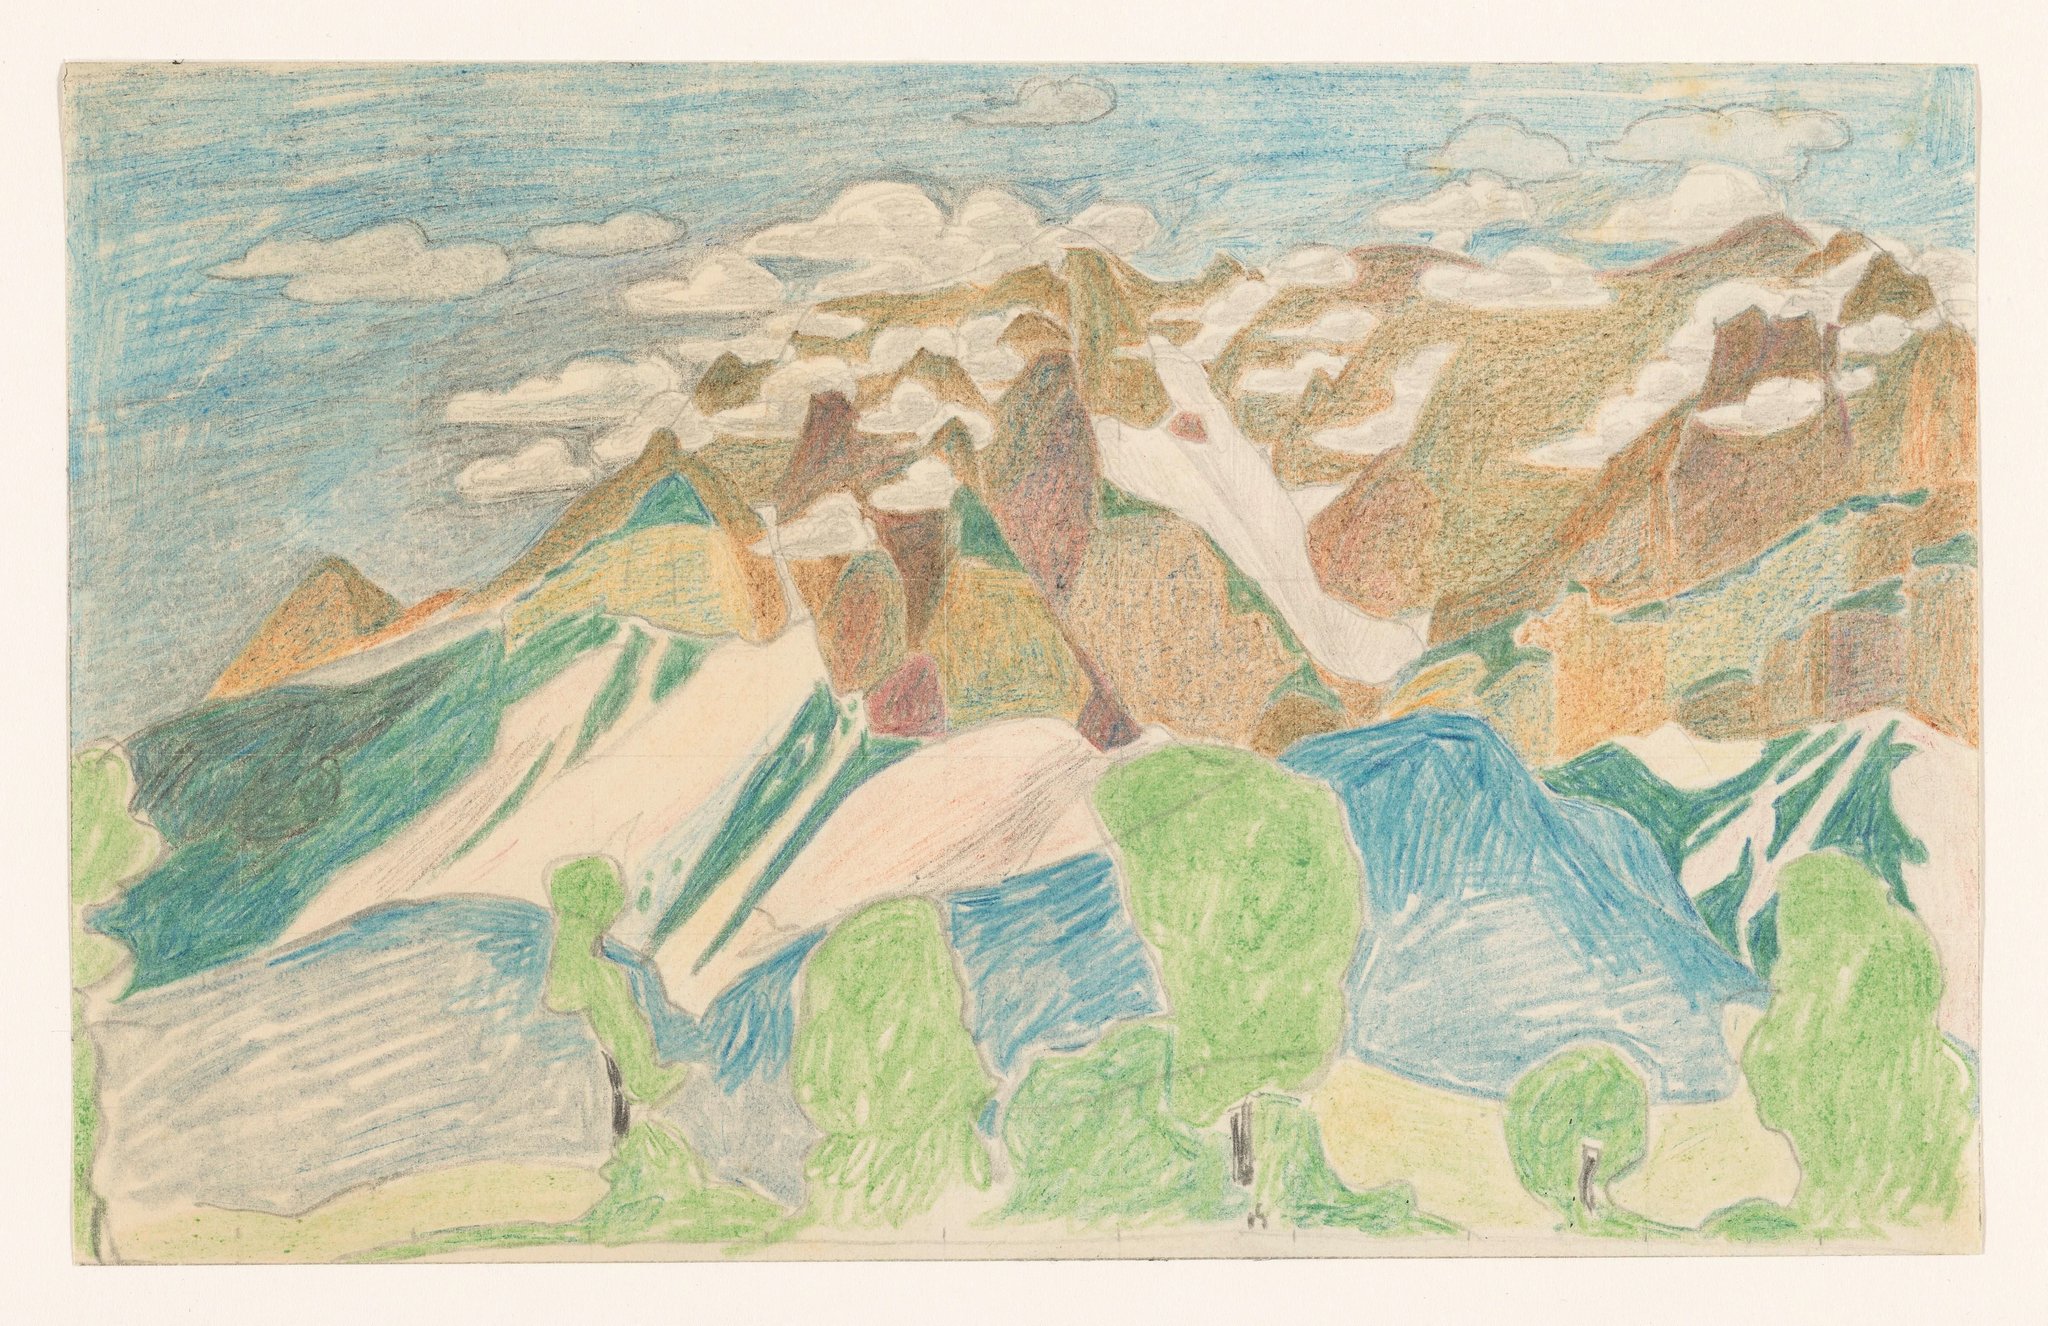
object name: drawing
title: Berglandschap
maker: reijer stolk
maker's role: draughtsman, print maker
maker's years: 1896-1945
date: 1906-1945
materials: chalk, paper, pencil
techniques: drawing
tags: landscapes, mountains, italy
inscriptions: collector's mark: Lugt 2228